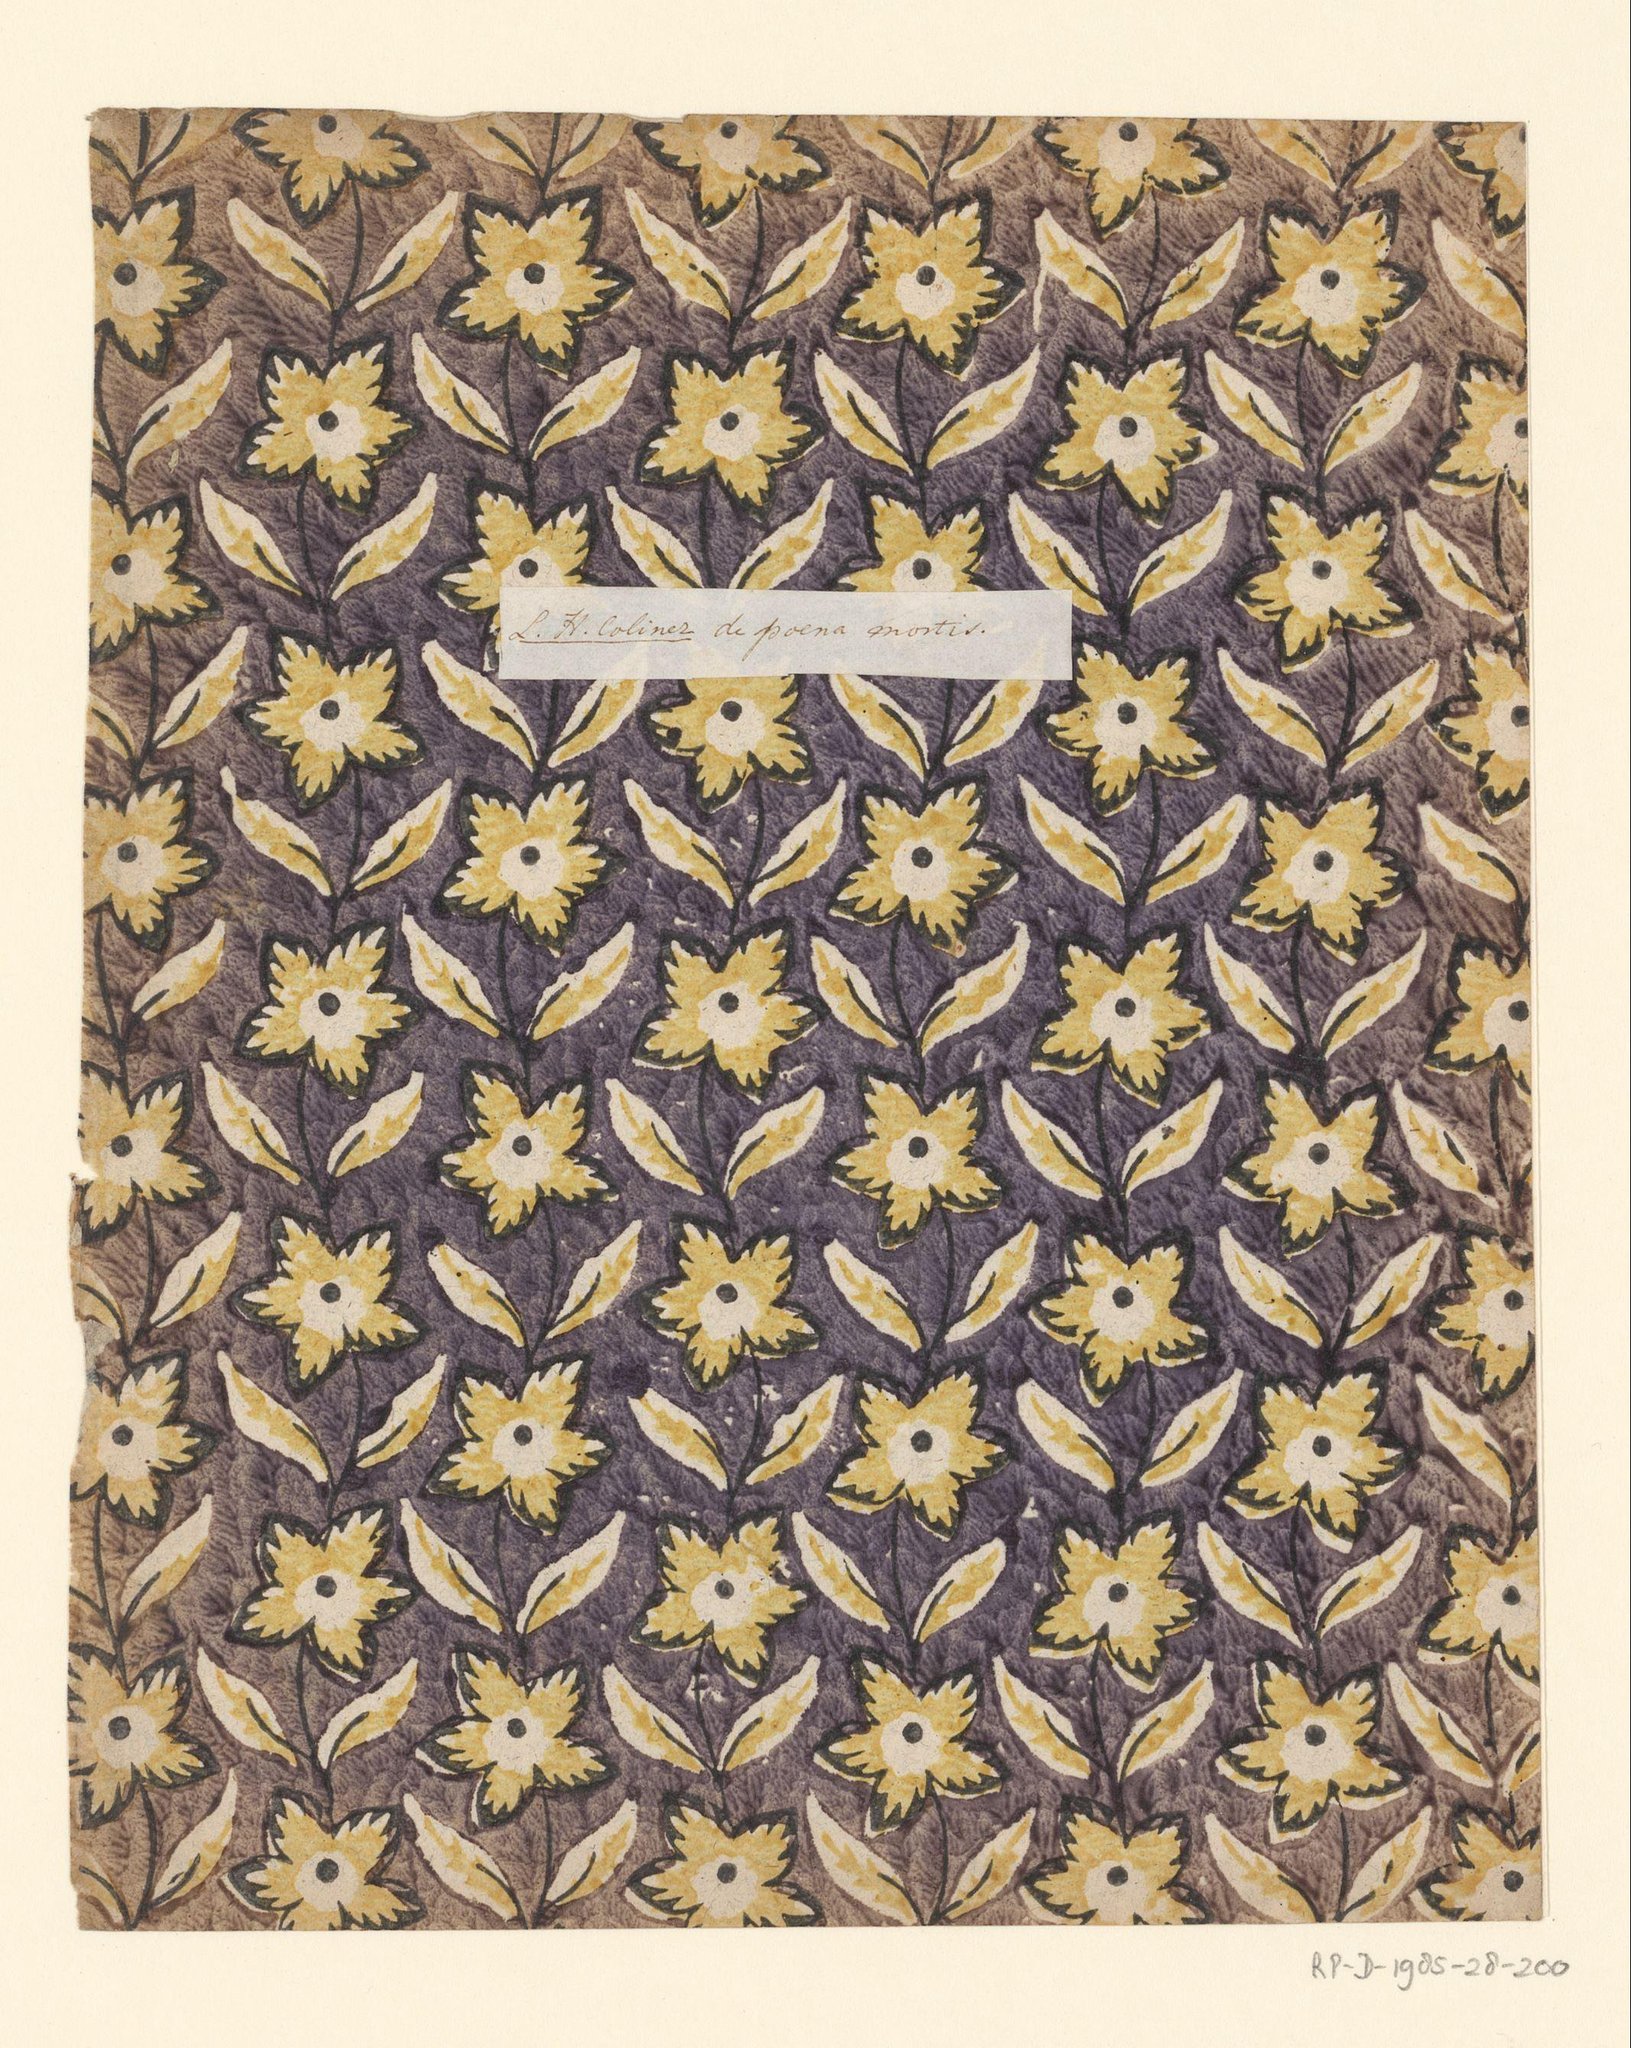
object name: printed paper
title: Blad met banenpatroon van verticale ranken met bloemen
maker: Anonymous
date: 1750-1900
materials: paper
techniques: printing block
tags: ornament derived from plant forms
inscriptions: collector's mark: Lugt 2760, collector's mark: Lugt 2228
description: Blad met banenpatroon van verticale ranken met bloemen. Met etiket met opschrift: 'L.H. Colinez, de poena mortis.' Helft van een omslag.